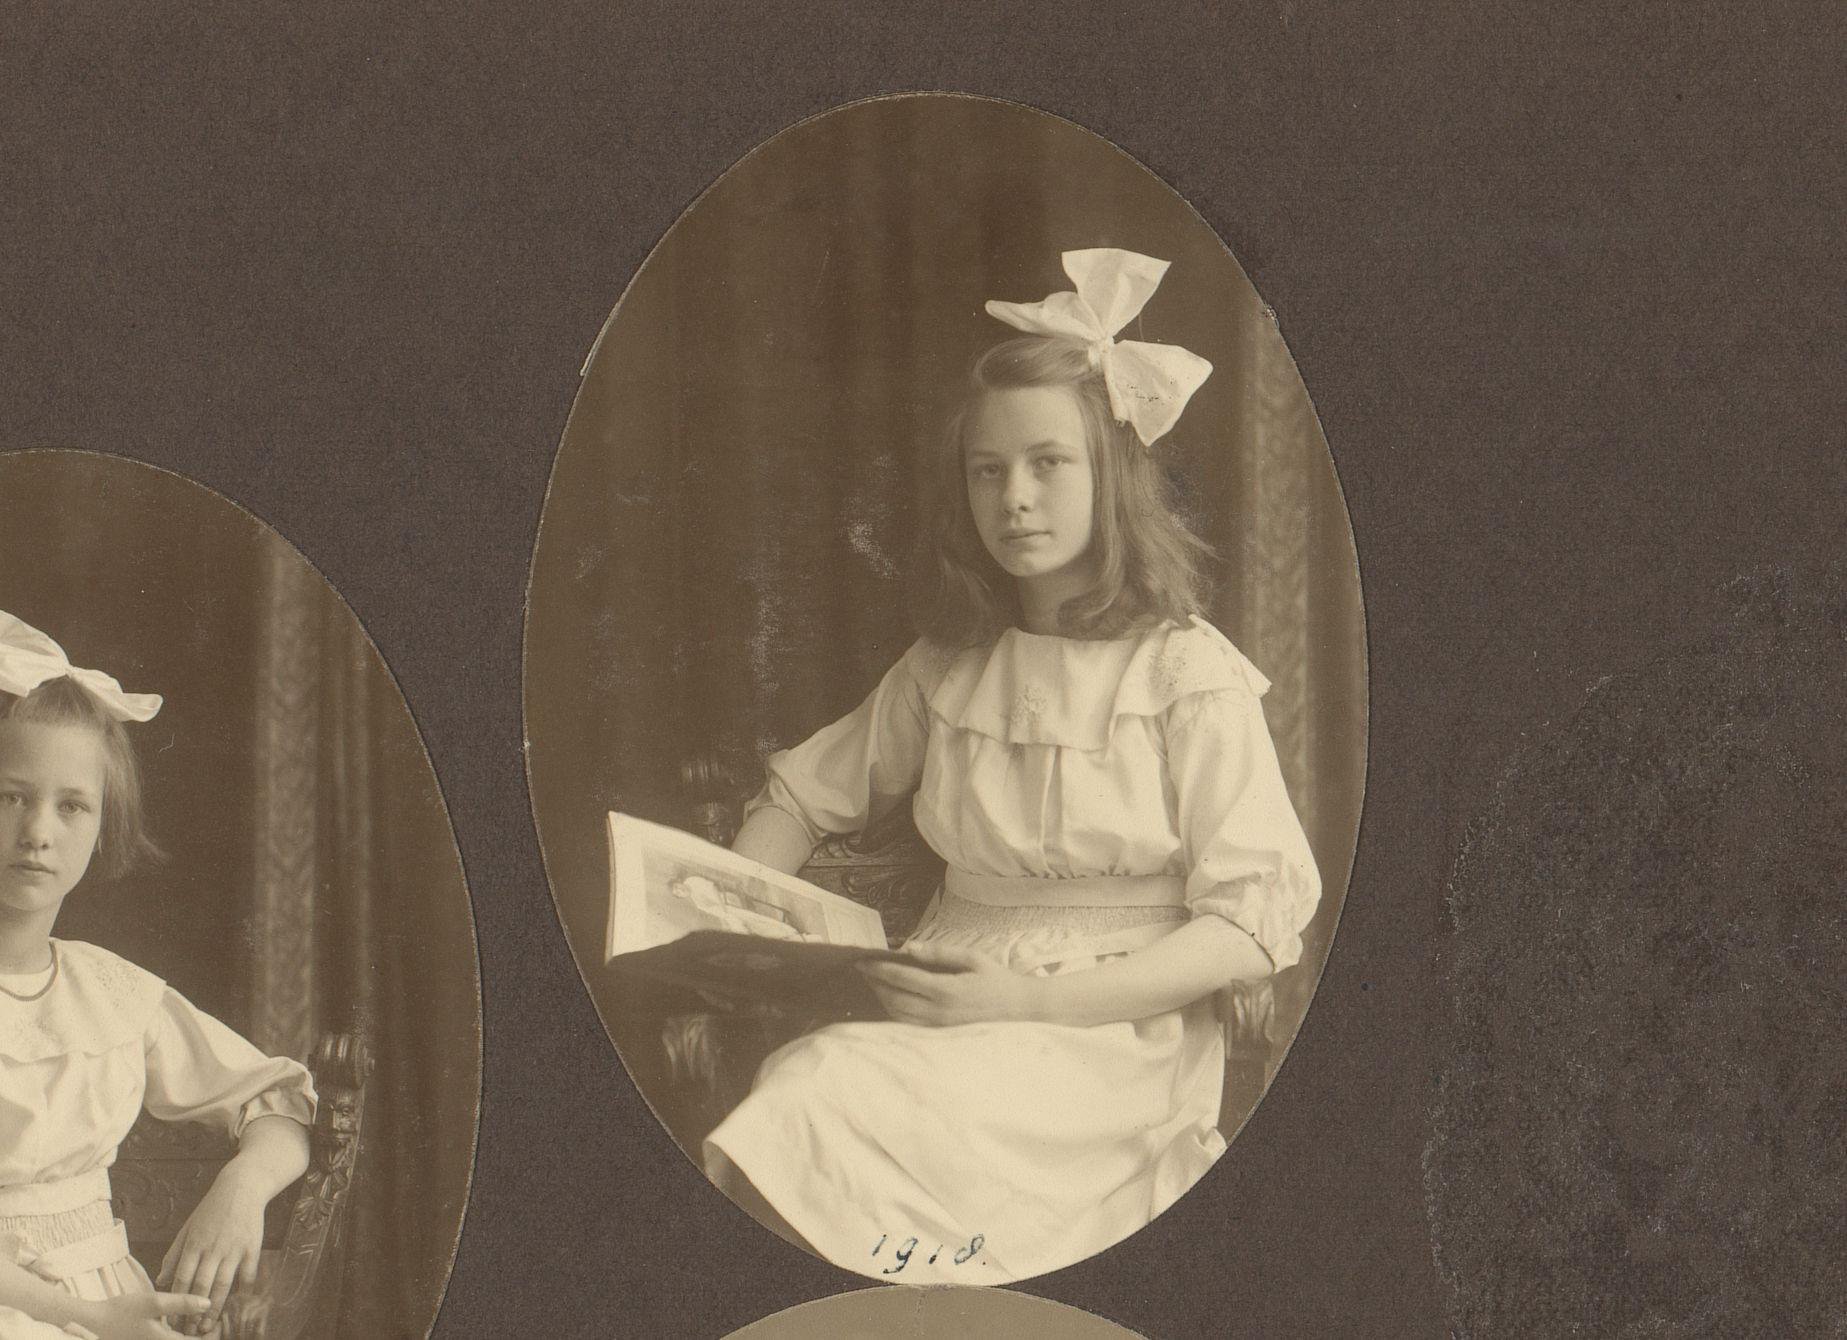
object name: photograph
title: Portret van Joanna Diepenbrock zittend met een boek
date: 1918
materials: paper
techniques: cutting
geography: netherlands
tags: historical persons - bb - woman, book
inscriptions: date: ‘1918.’